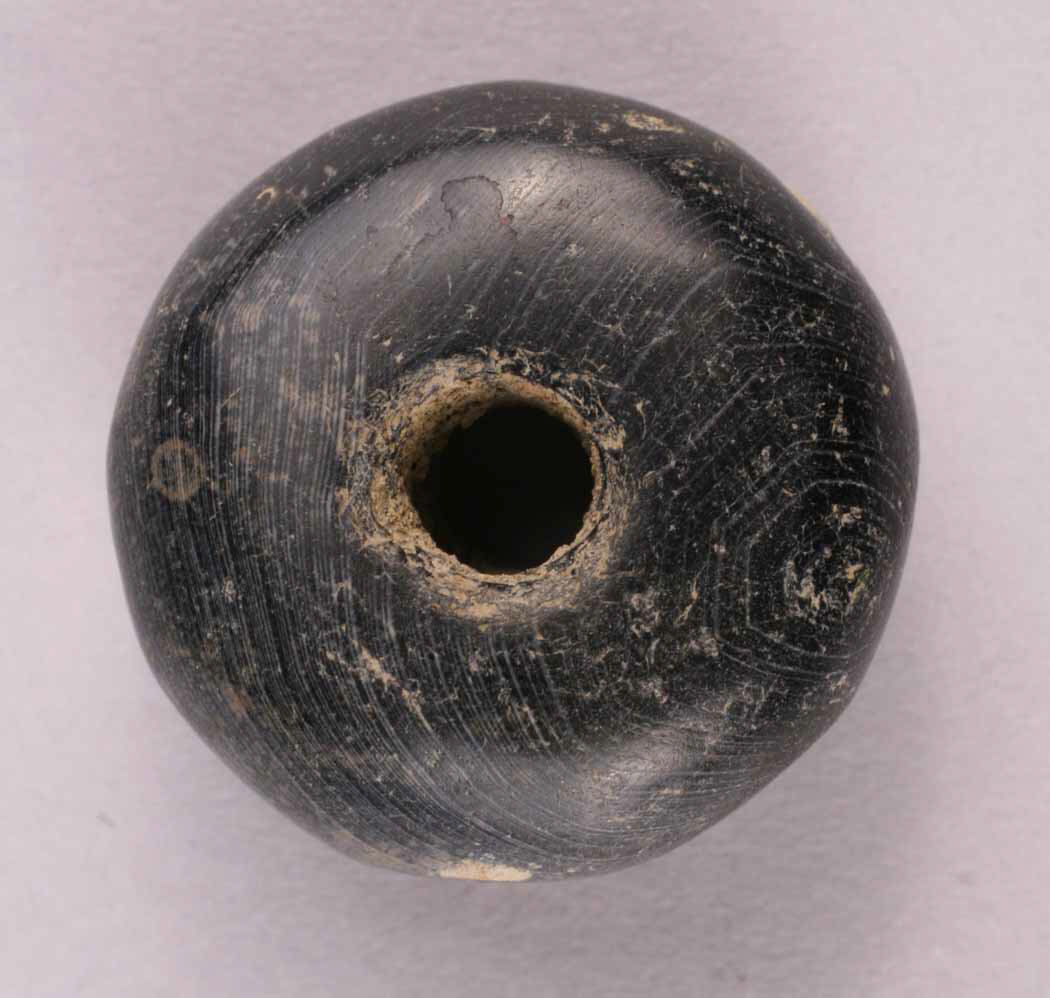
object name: bead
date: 701-1300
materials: stone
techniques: cutting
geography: iran